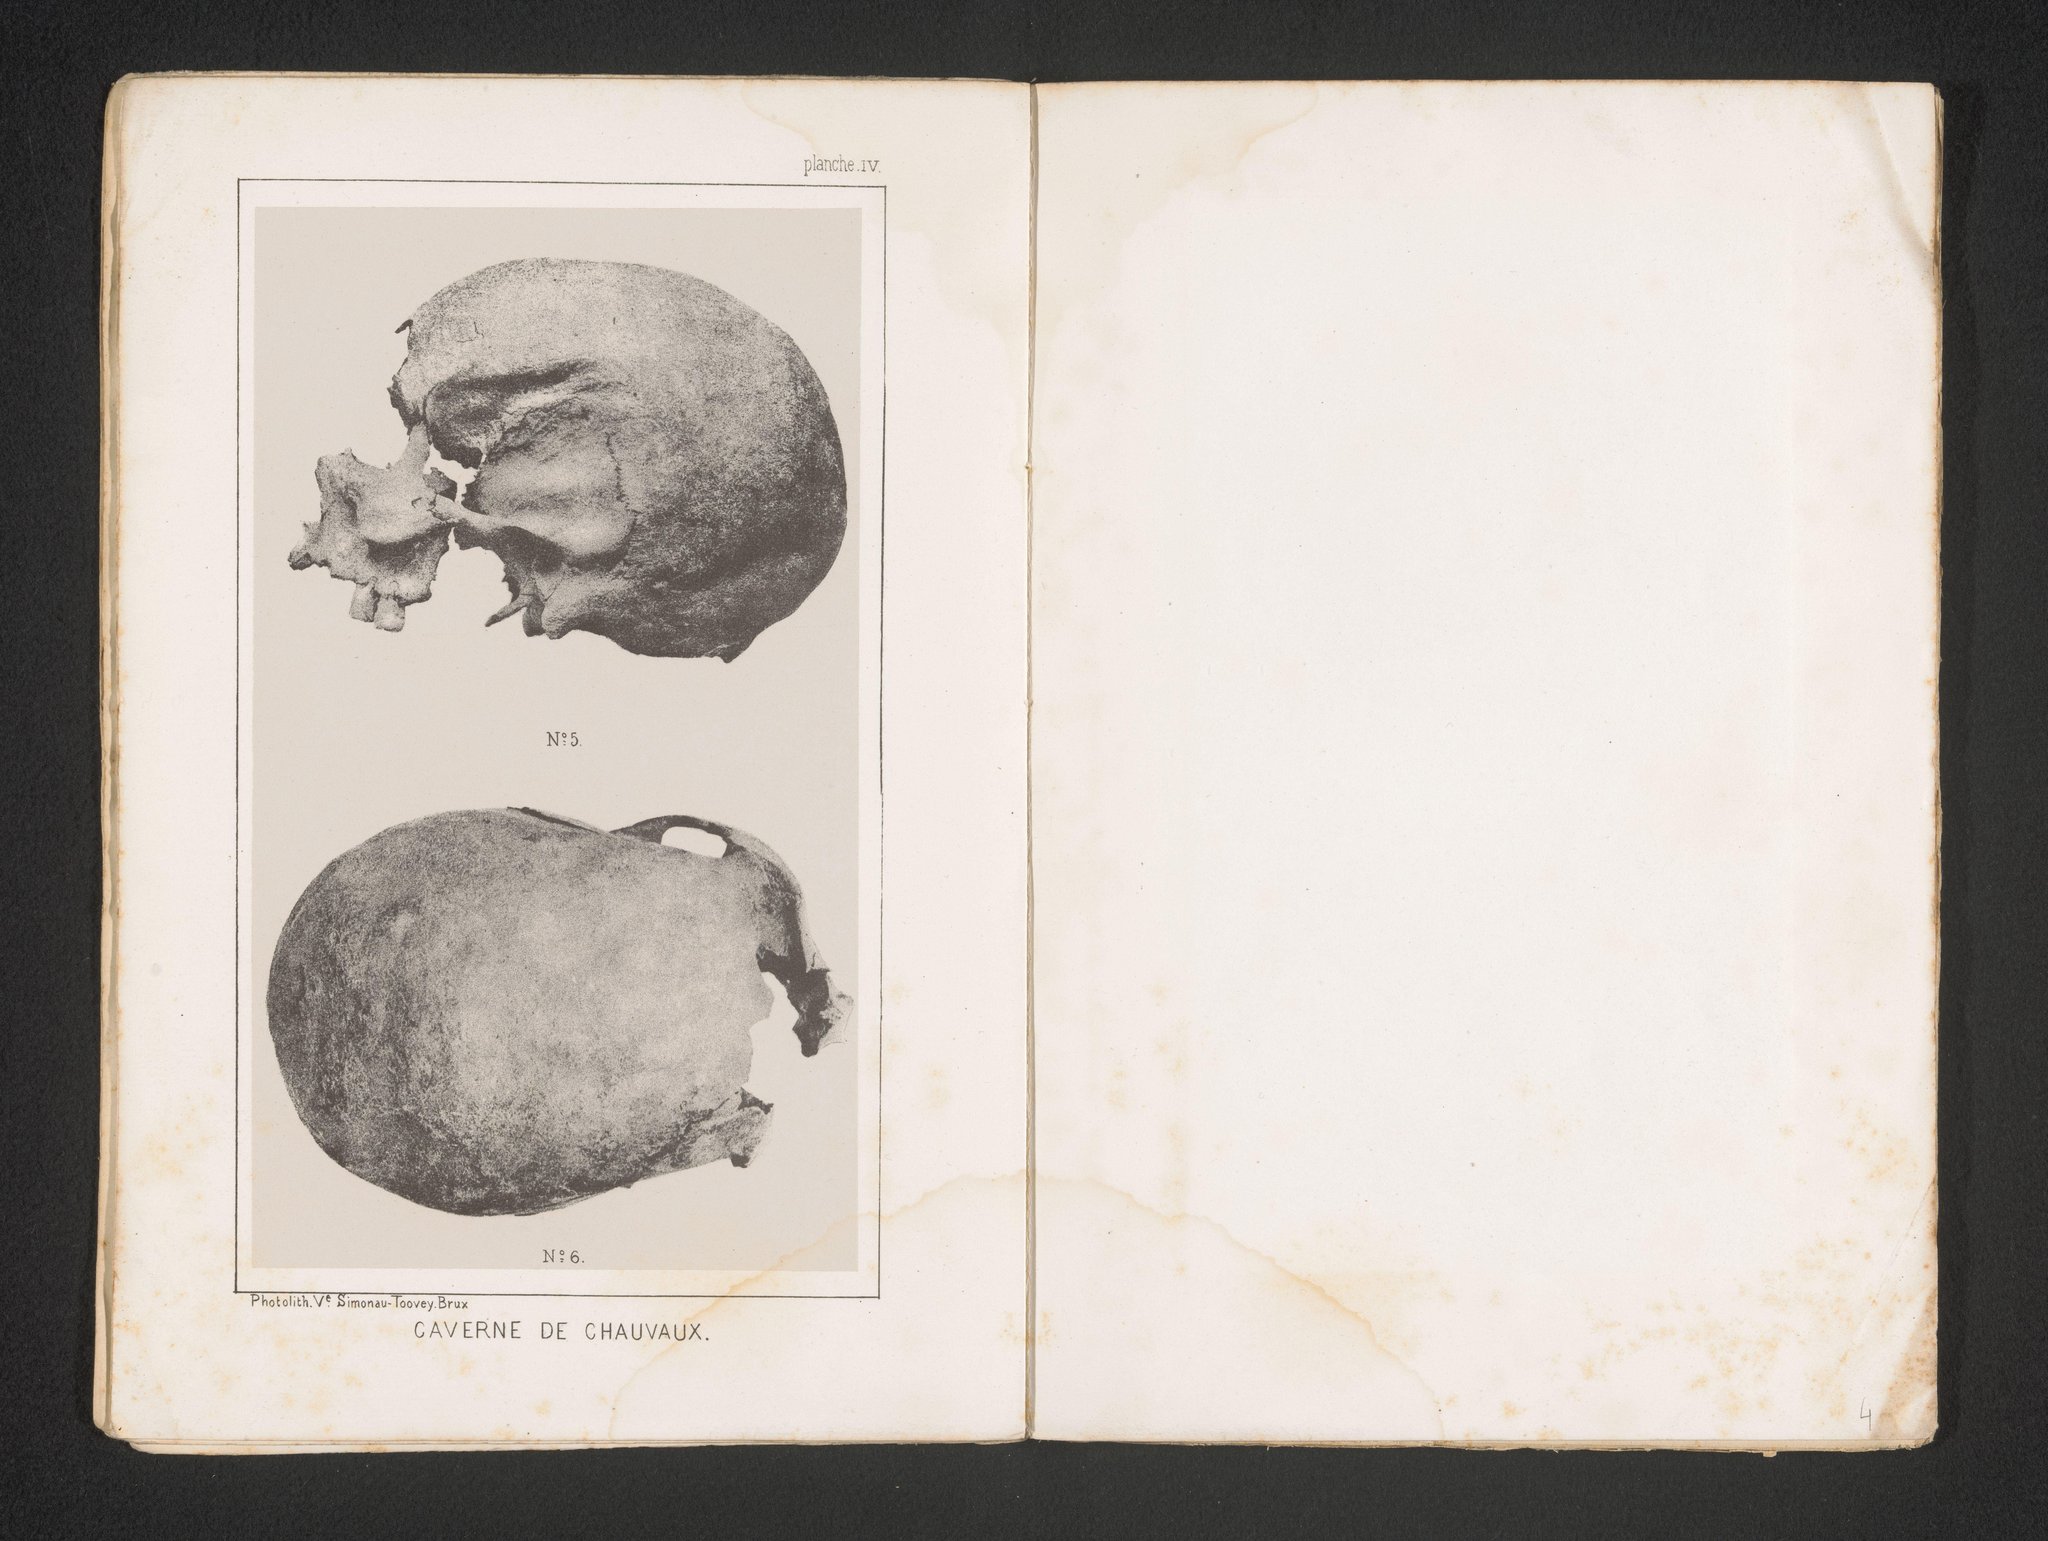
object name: page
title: Caverne de Chauvaux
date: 1870-1875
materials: paper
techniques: photolithography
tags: (human) skull